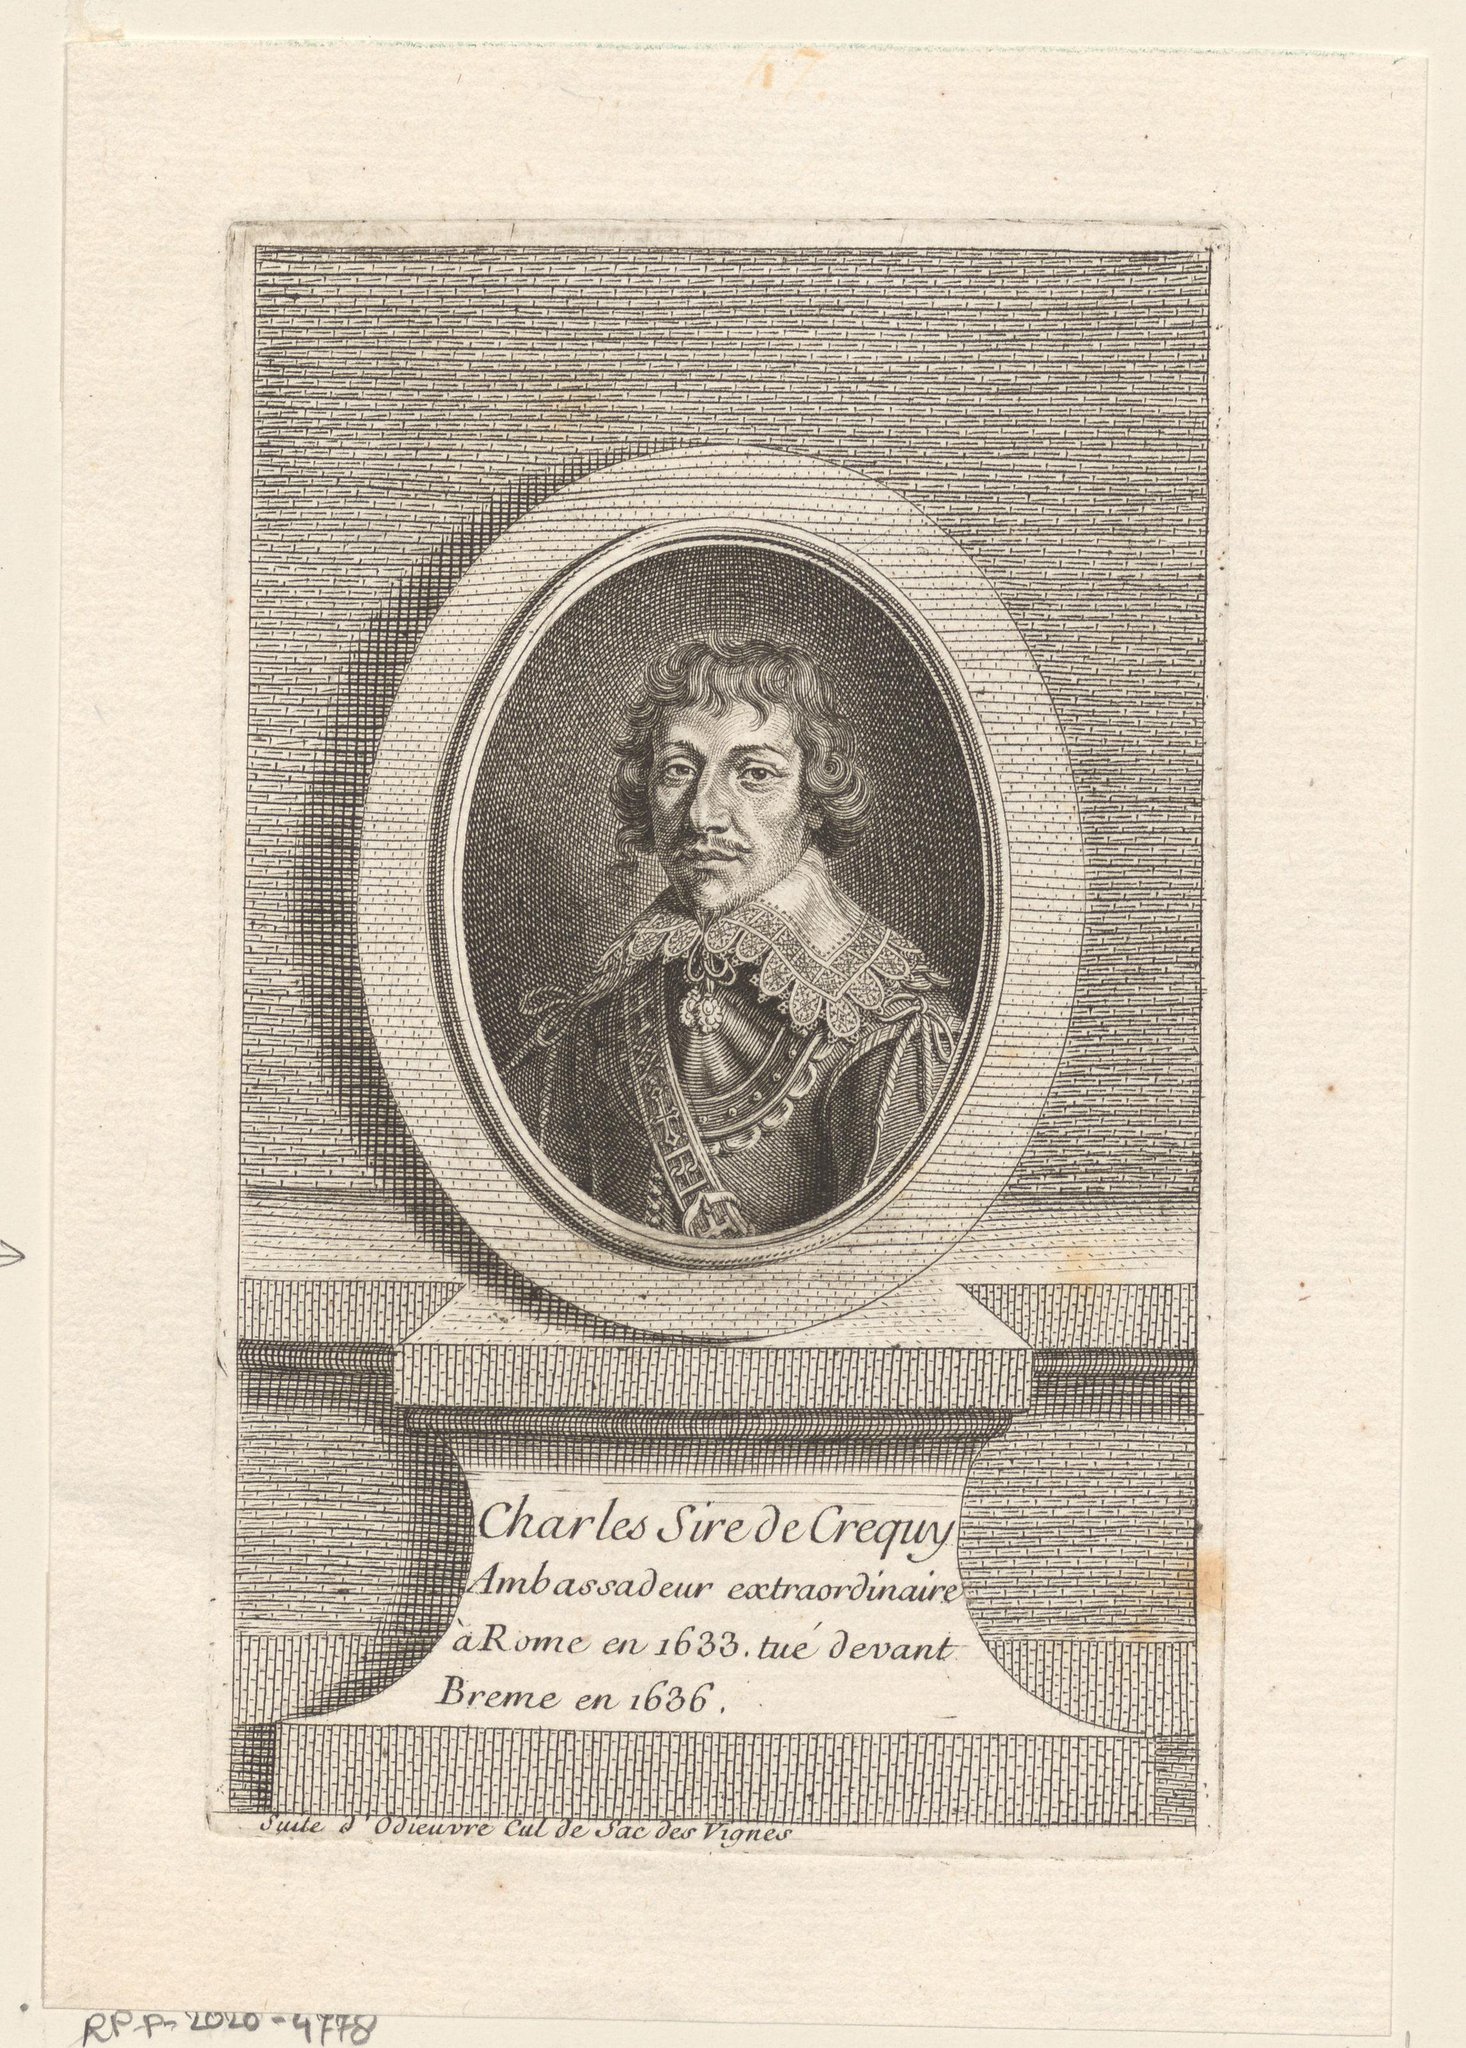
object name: print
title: Portret van Charles de Crequi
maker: michel lasne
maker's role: print maker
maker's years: 1590-1667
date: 1636-1667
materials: paper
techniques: engraving, etching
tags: historical persons